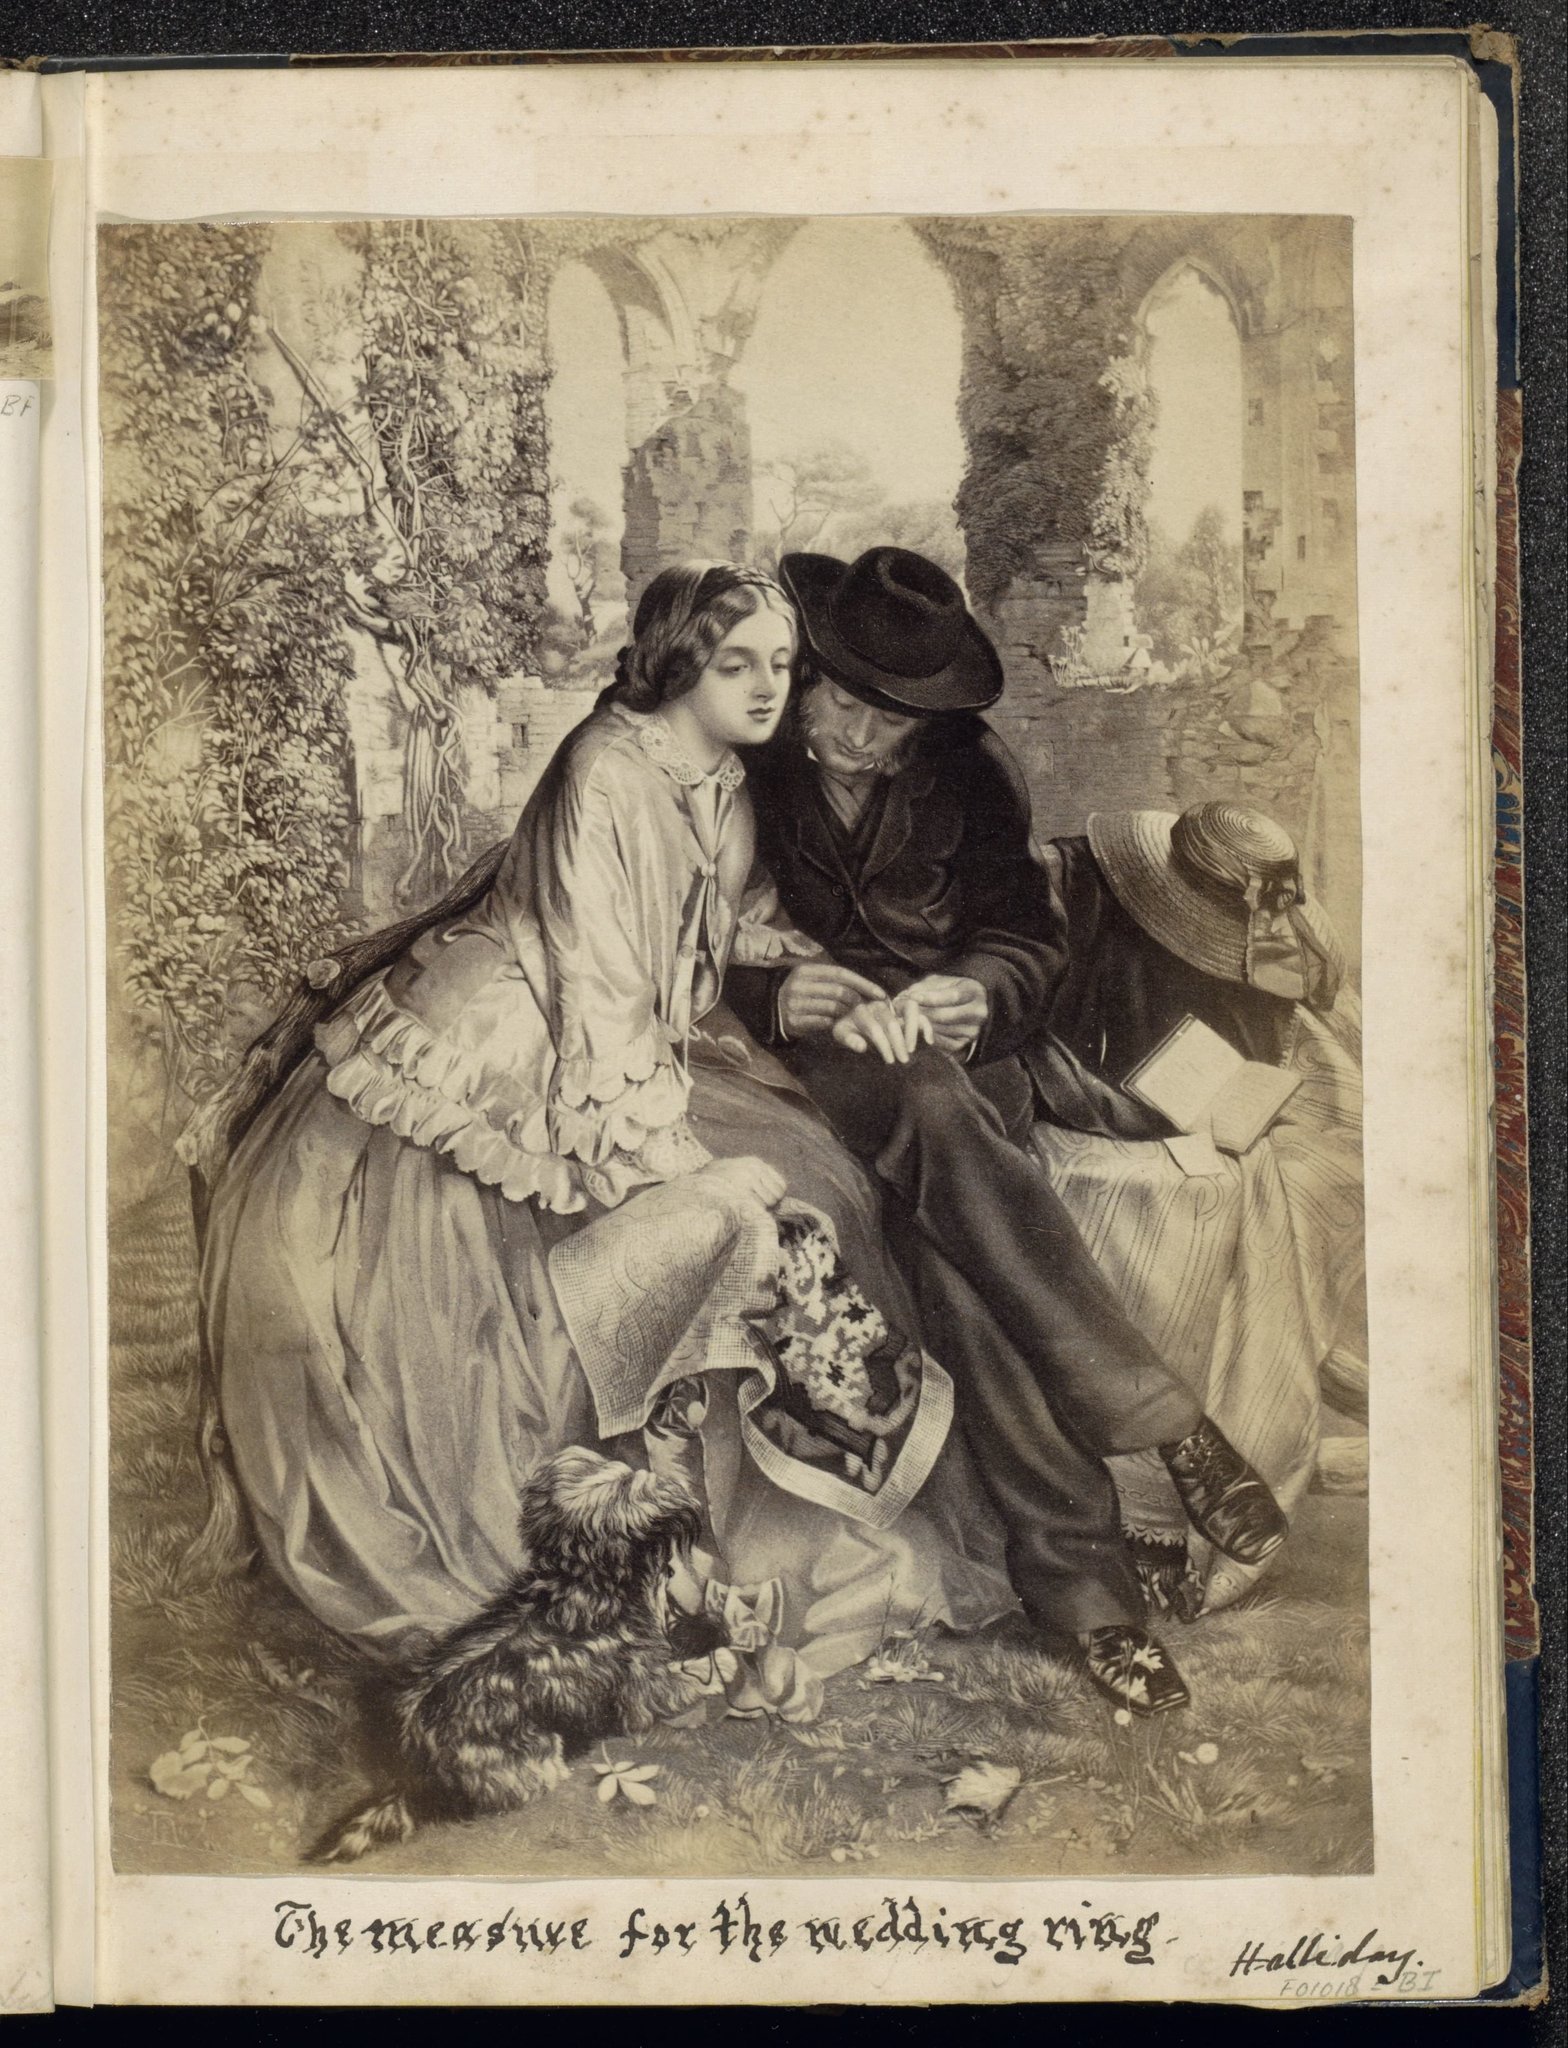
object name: reproduction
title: Fotoreproductie van (vermoedelijk) een prent naar een schilderij van Michael Frederick Halliday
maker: Anonymous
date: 1860-1870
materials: paper, photographic support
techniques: albumen print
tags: couple of lovers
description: Onderdeel van Engels familiealbum met foto's van personen, reizen, cricket en kunstwerken.